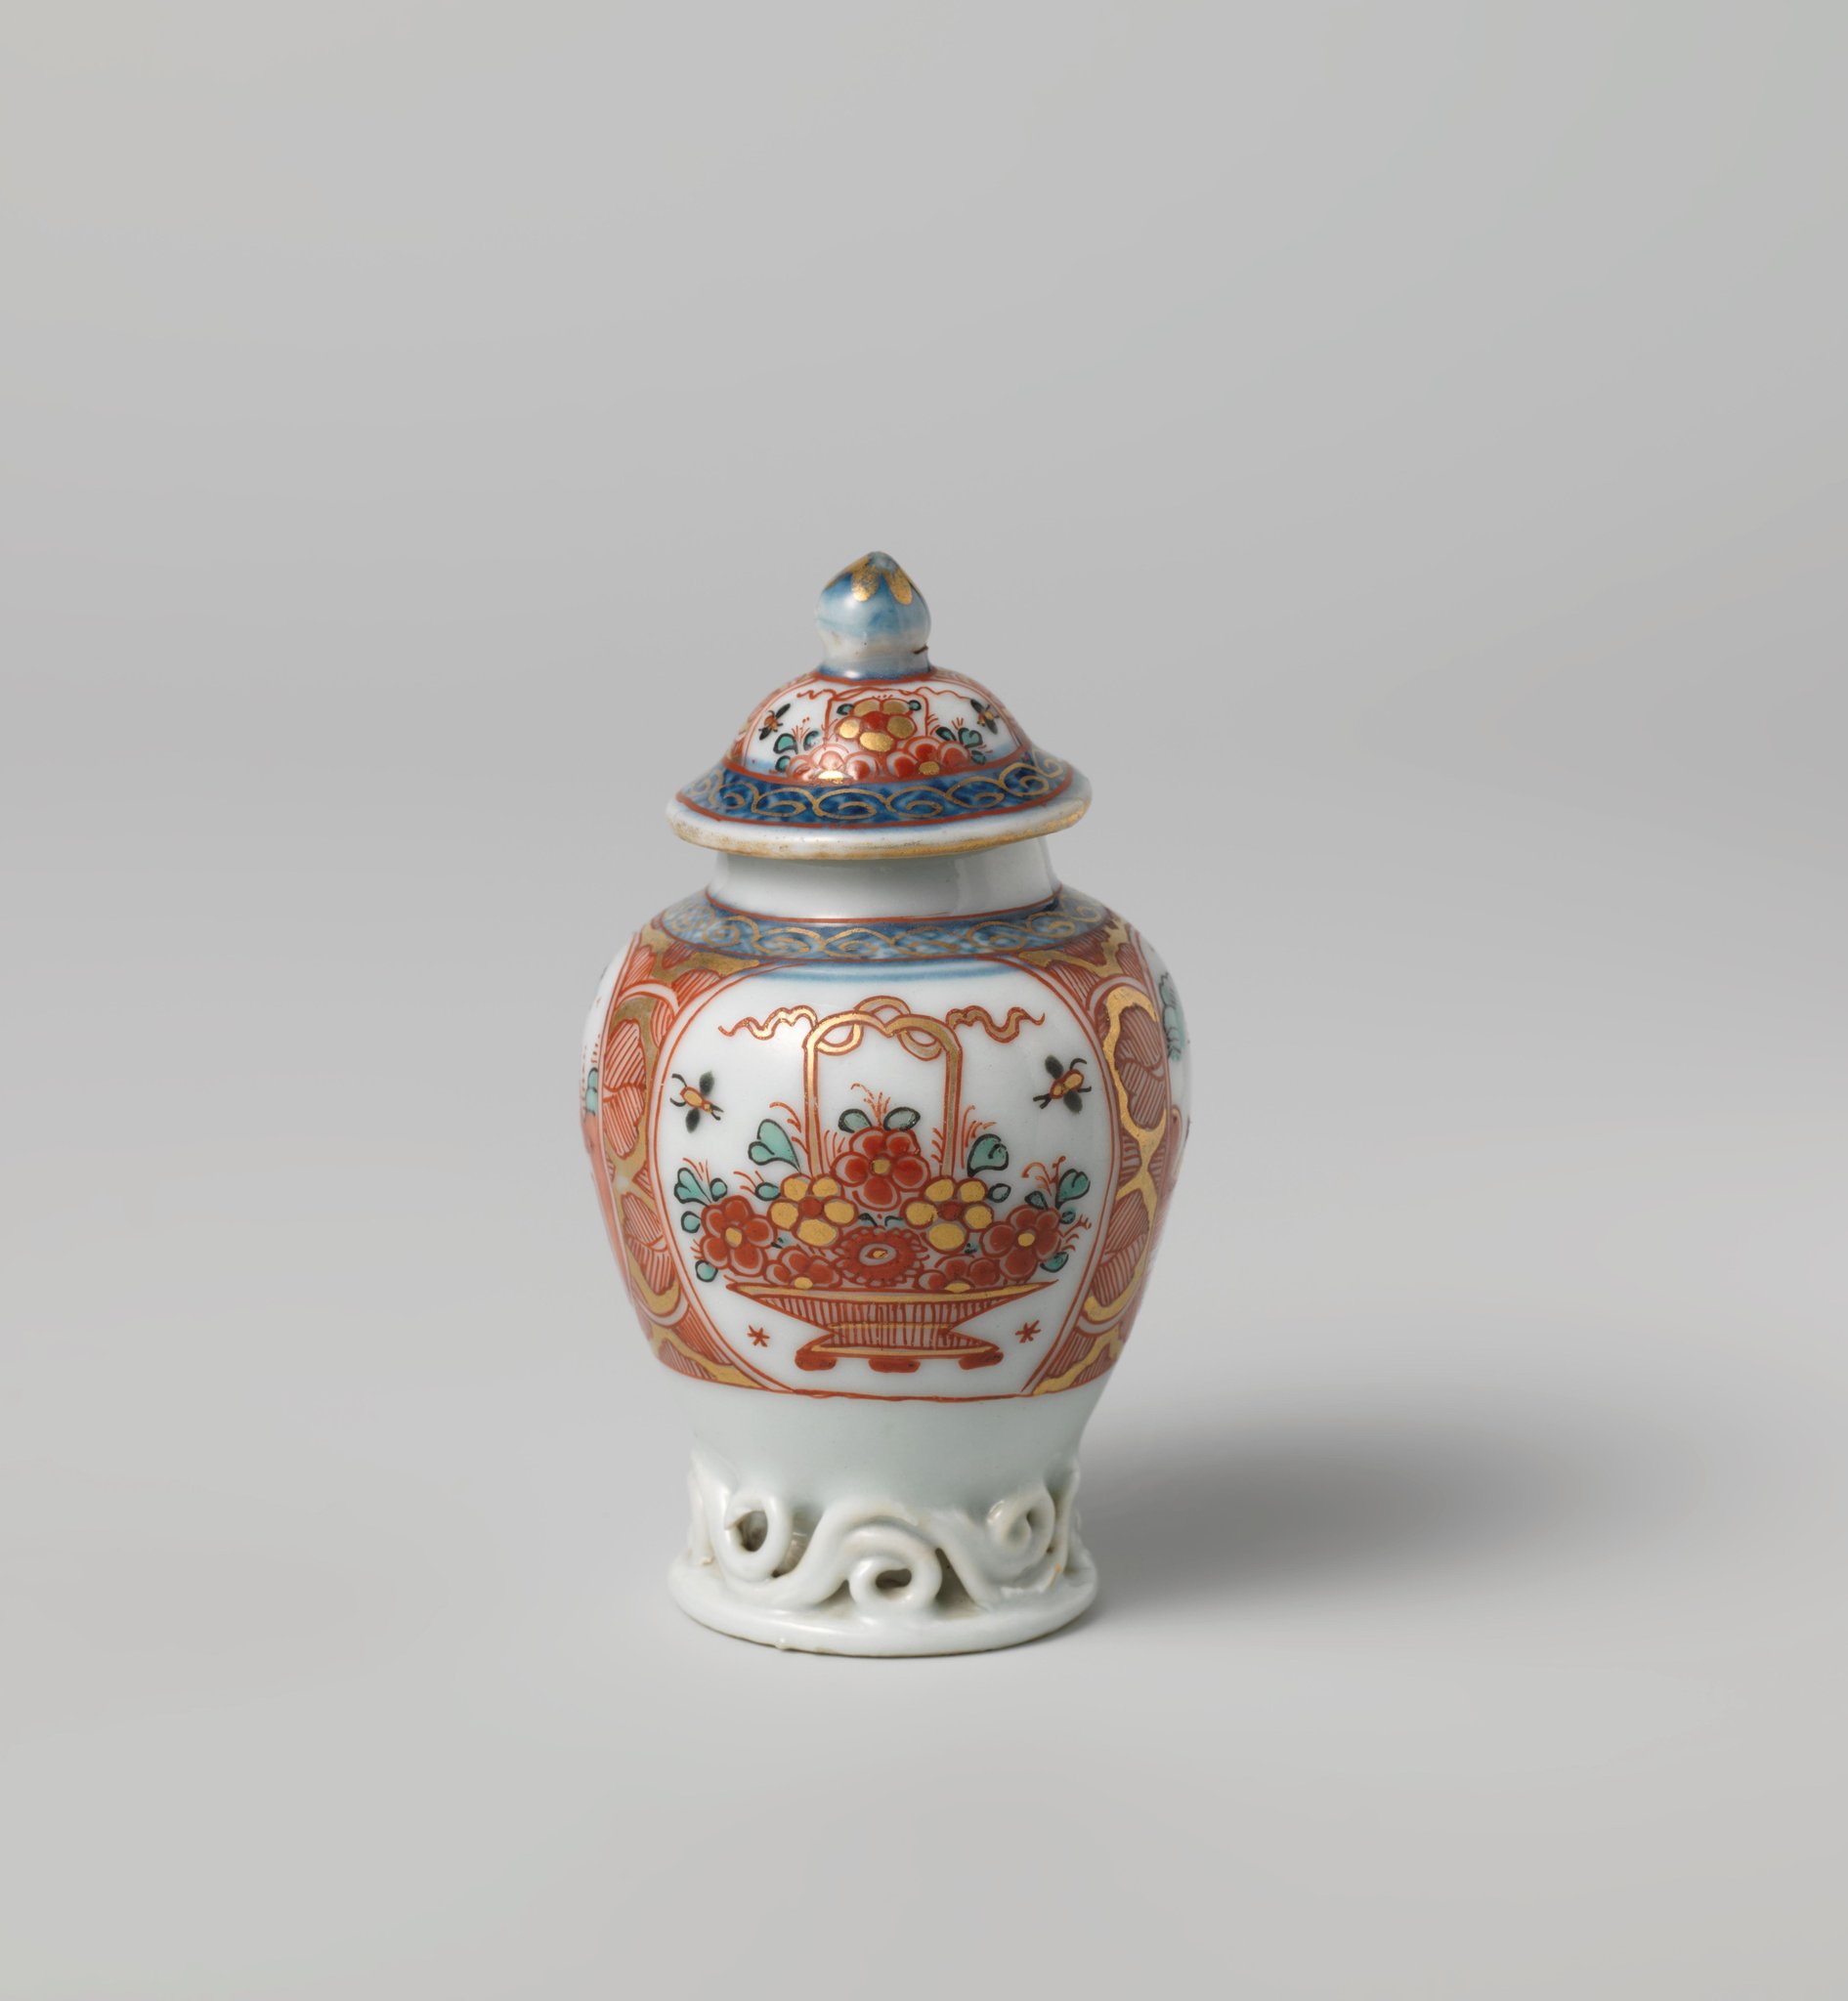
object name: tea caddy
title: Ovoid tea caddy with flower basket and water landscape in panels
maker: Anonymous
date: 1725-1749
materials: cobalt, glaze, gold, paint, porcelain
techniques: firing, forming, gilding, turning, vitrification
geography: japan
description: Kleine theebus van porselein met eivormig lichaam en spreidende voet met een gemodelleerde band met krulwerk, beschilderd in onderglazuur blauw en op het glazuur rood, groen, zwart en goud. Op de schouder een Japanse decoratieve band in onderglazuur blauw. In Nederland een decoratie toegevoegd in emailkleuren. Op de buik een brede decoratieve band met arceerwerk met daarin uitgespaard vier cartouches met afwisselend een rivierlandschap met een man in een boot en een bloemenmand met twee insecten; rond de schouder krulwerk. Overgedecoreerd (Amsterdams bont).